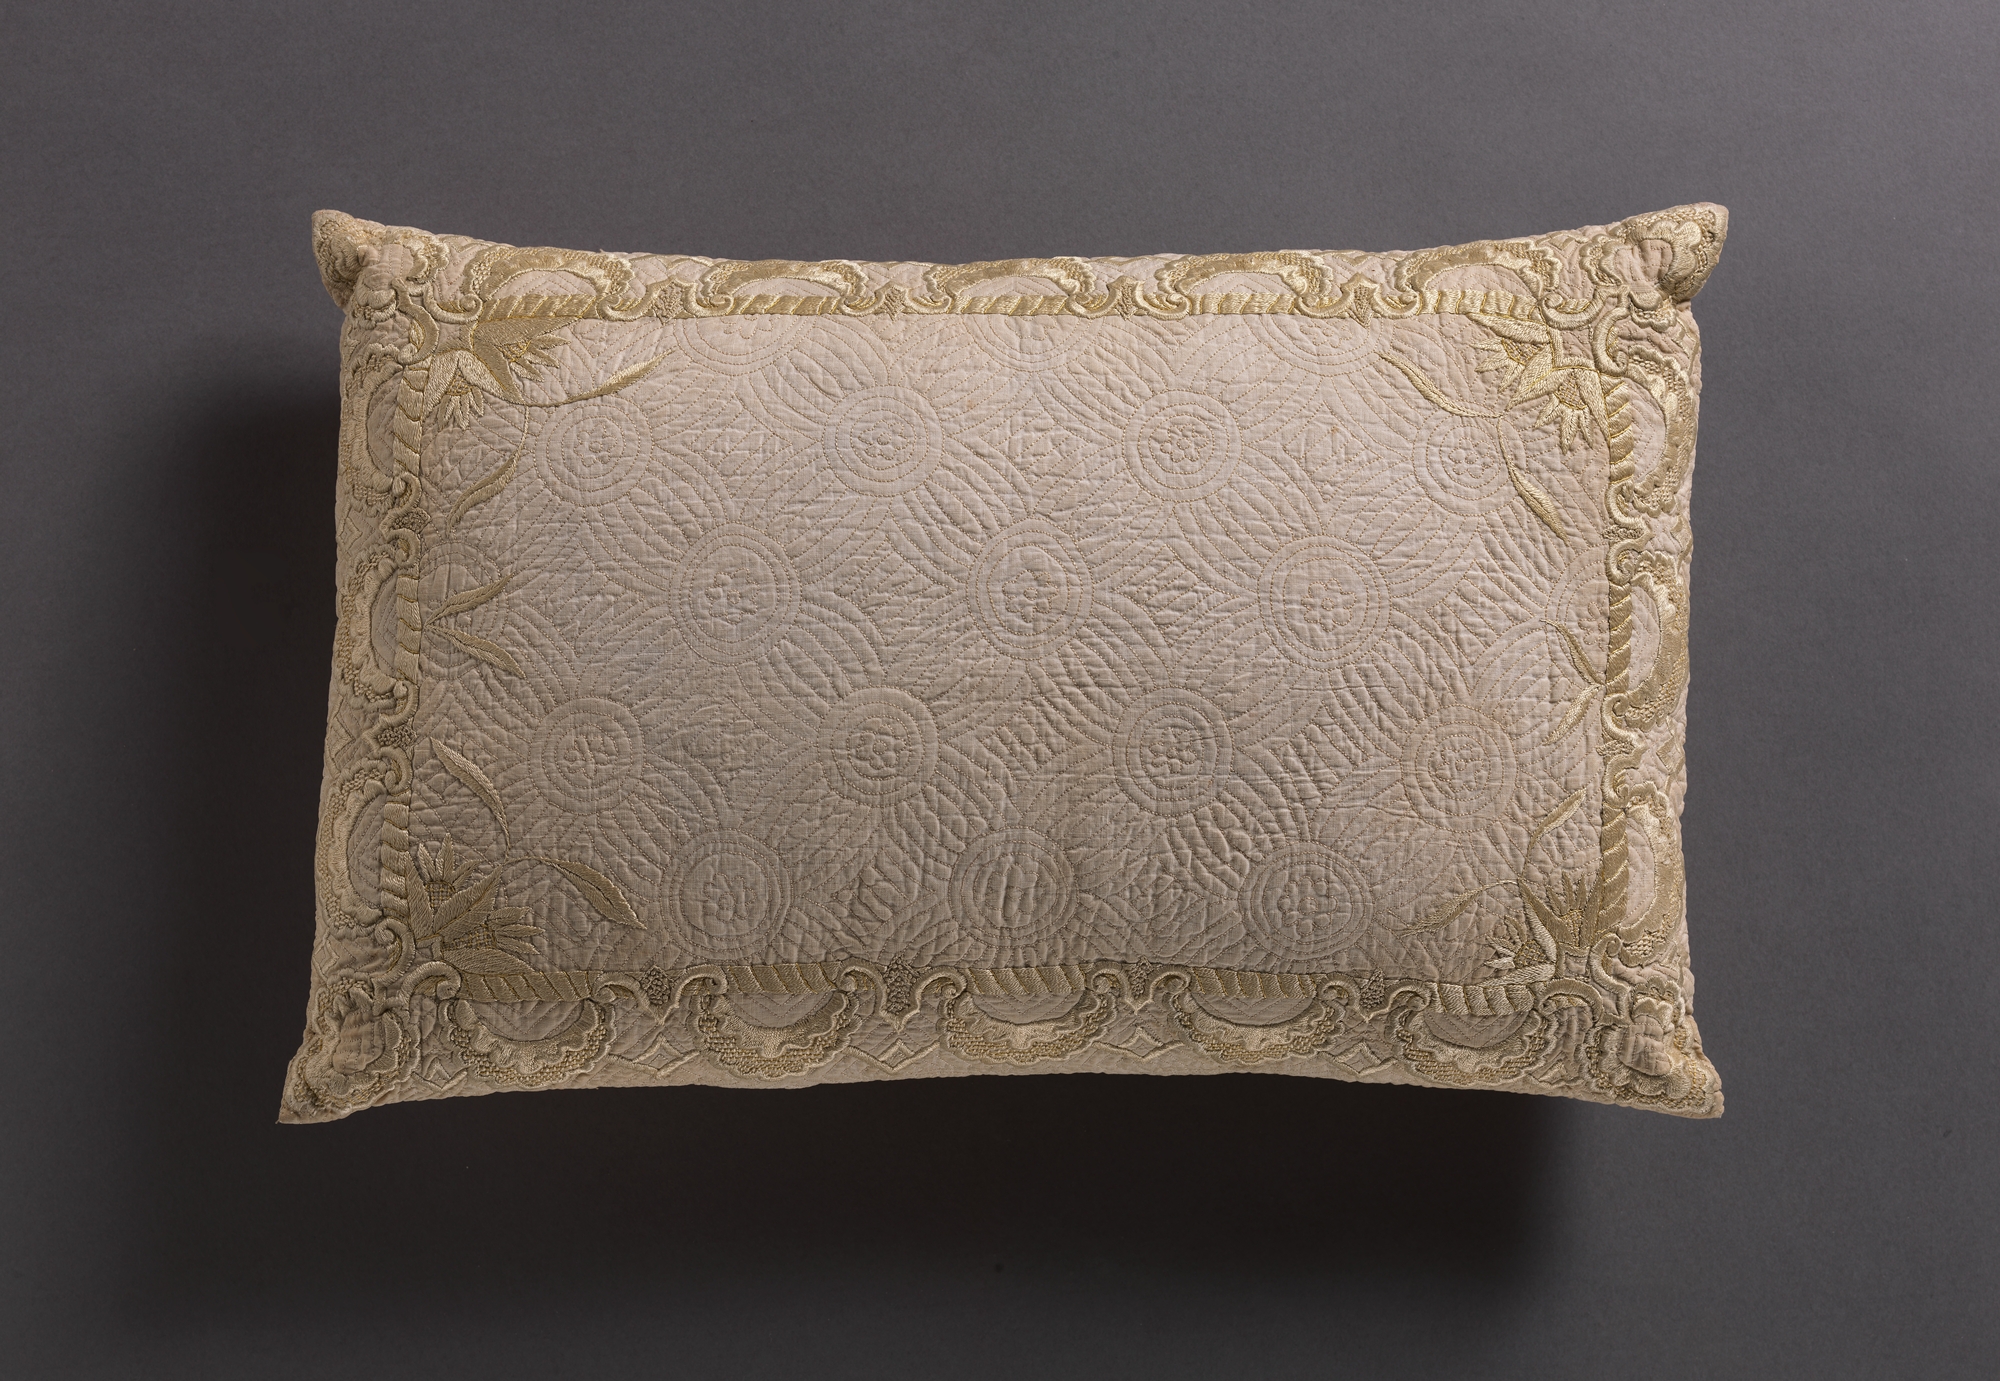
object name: pillow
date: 1667-1700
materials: cotton, silk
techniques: embroidery